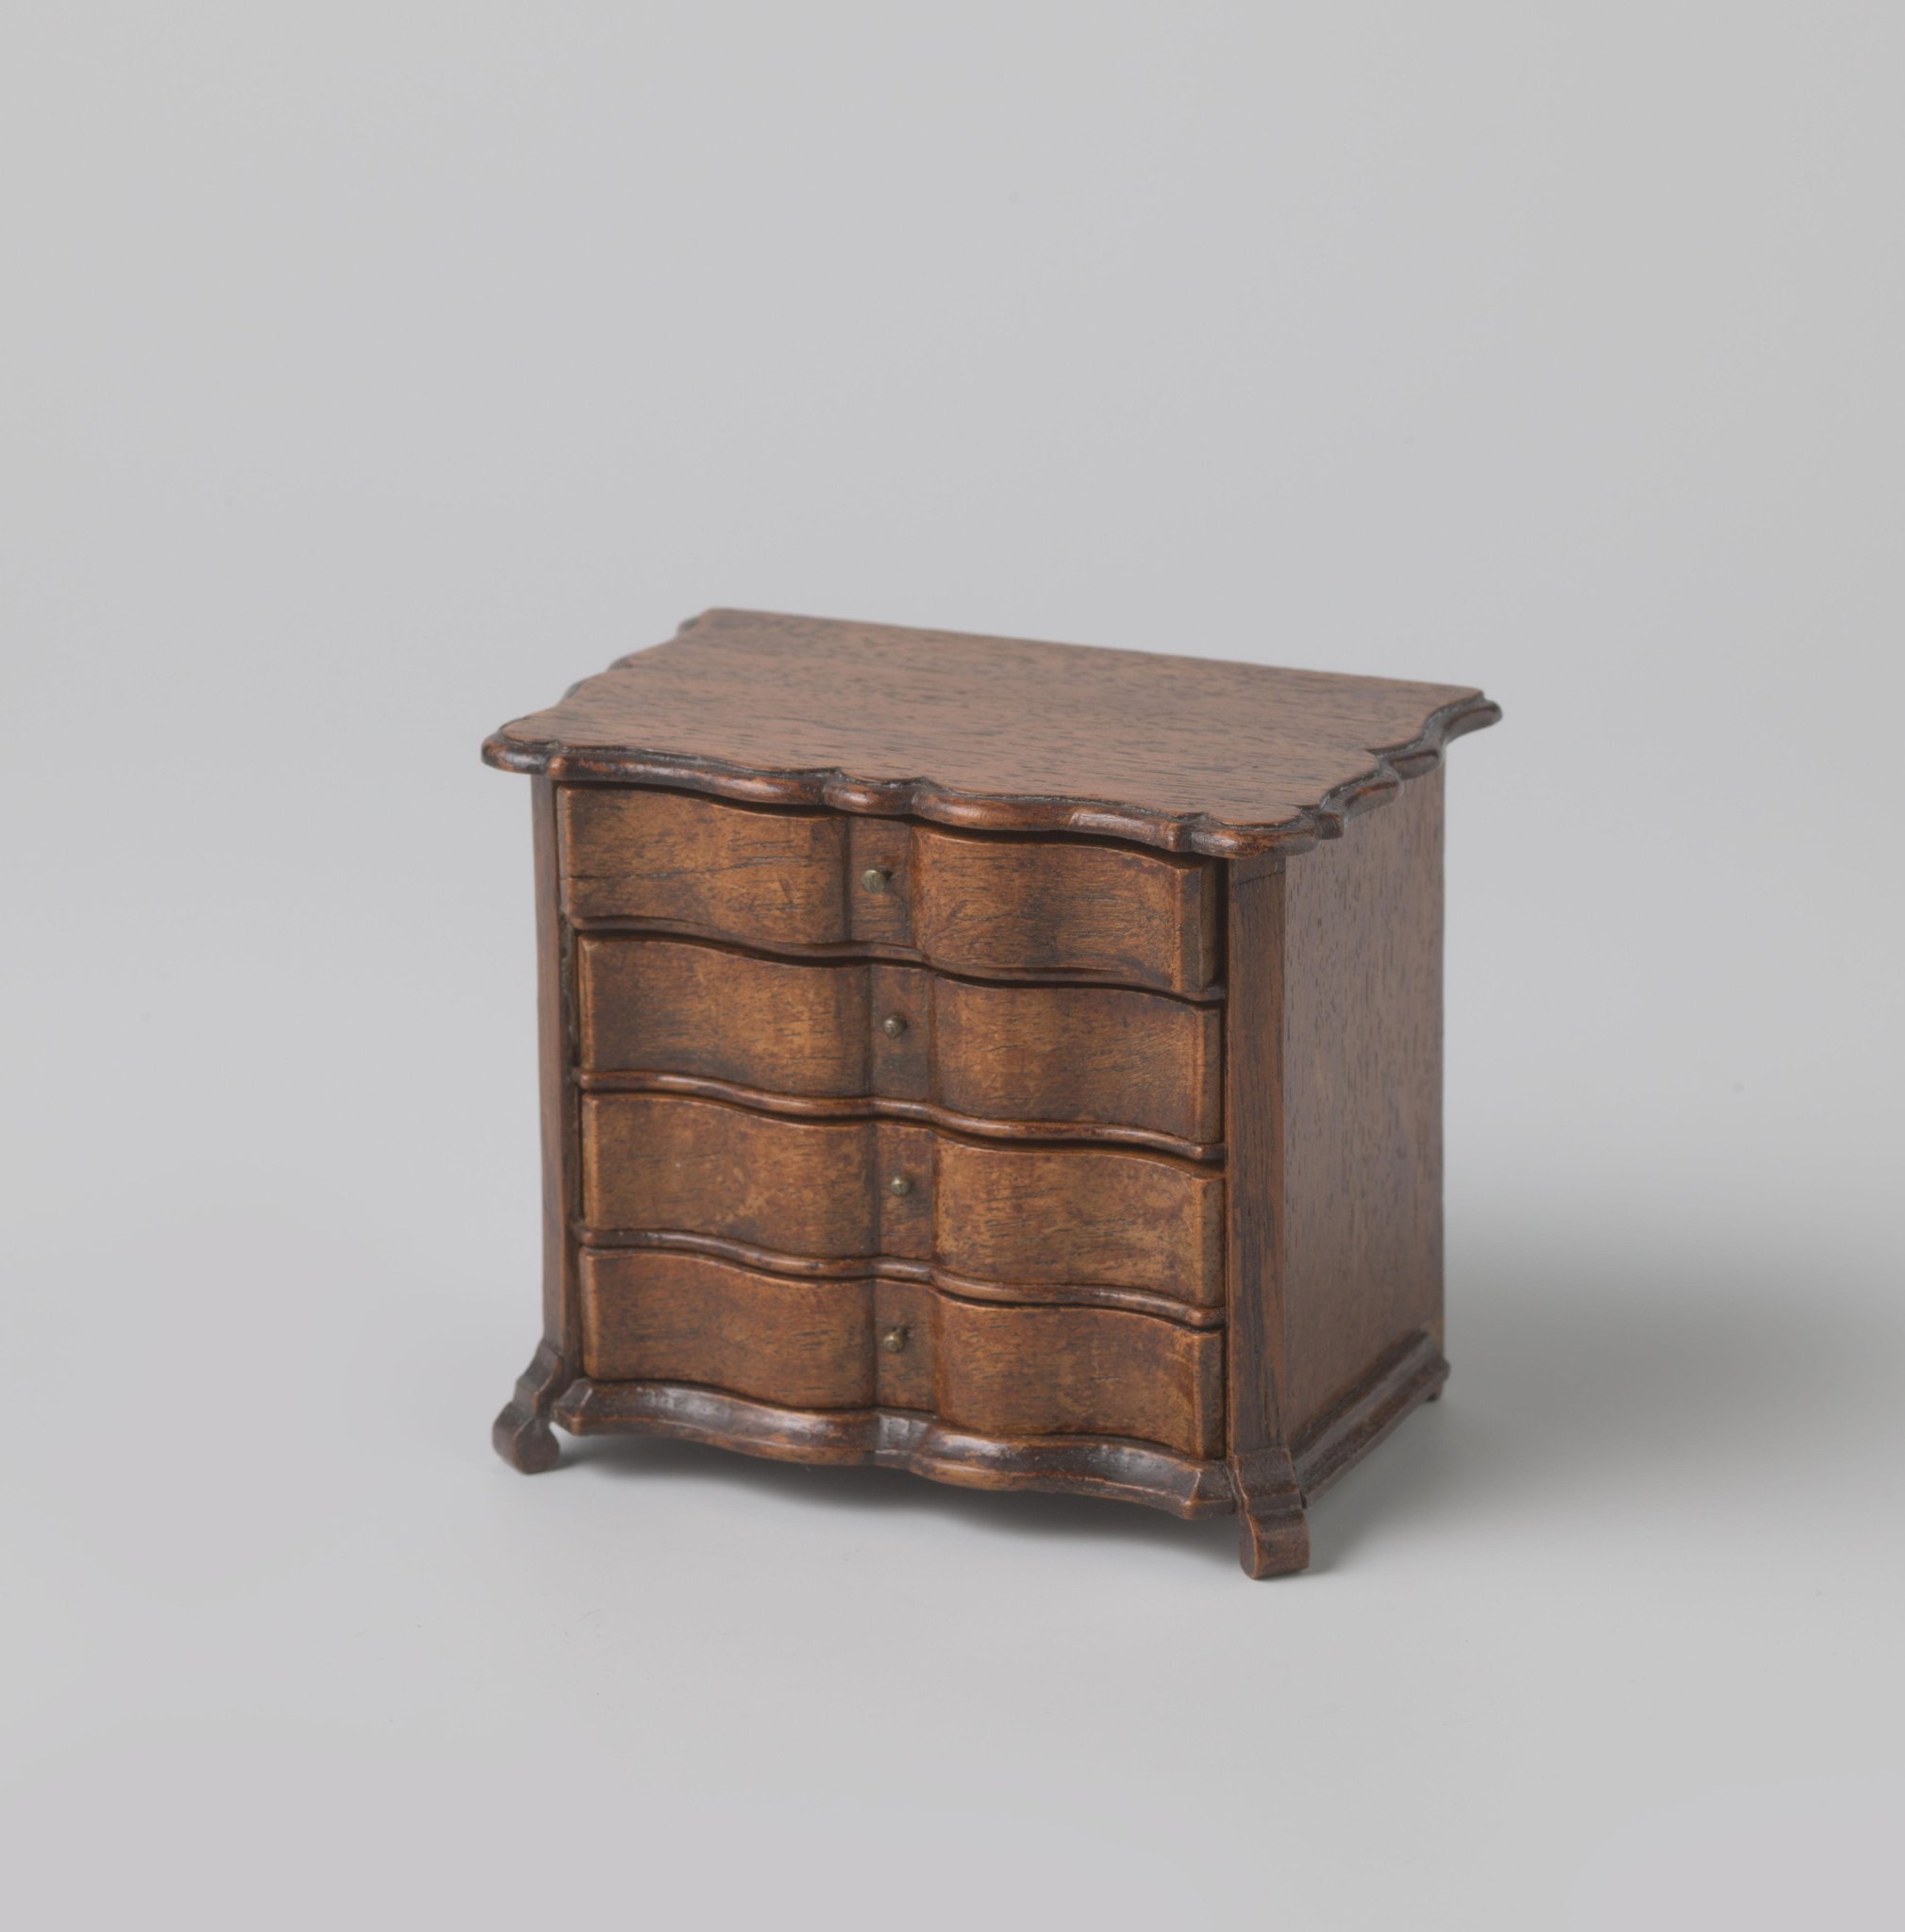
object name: commode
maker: Anonymous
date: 1750-1800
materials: wood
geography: northern netherlands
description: Commode in miniatuur van notenhout met vier laden en een geschulpt bovenblad. De voorste hoekstijlen zijn overhoeks geplaatst. Het front is gegolfd en in het midden van de laden zijn de trekkers bevestigd. De plintlijst is aan de voorkant eveneens gegolfd.